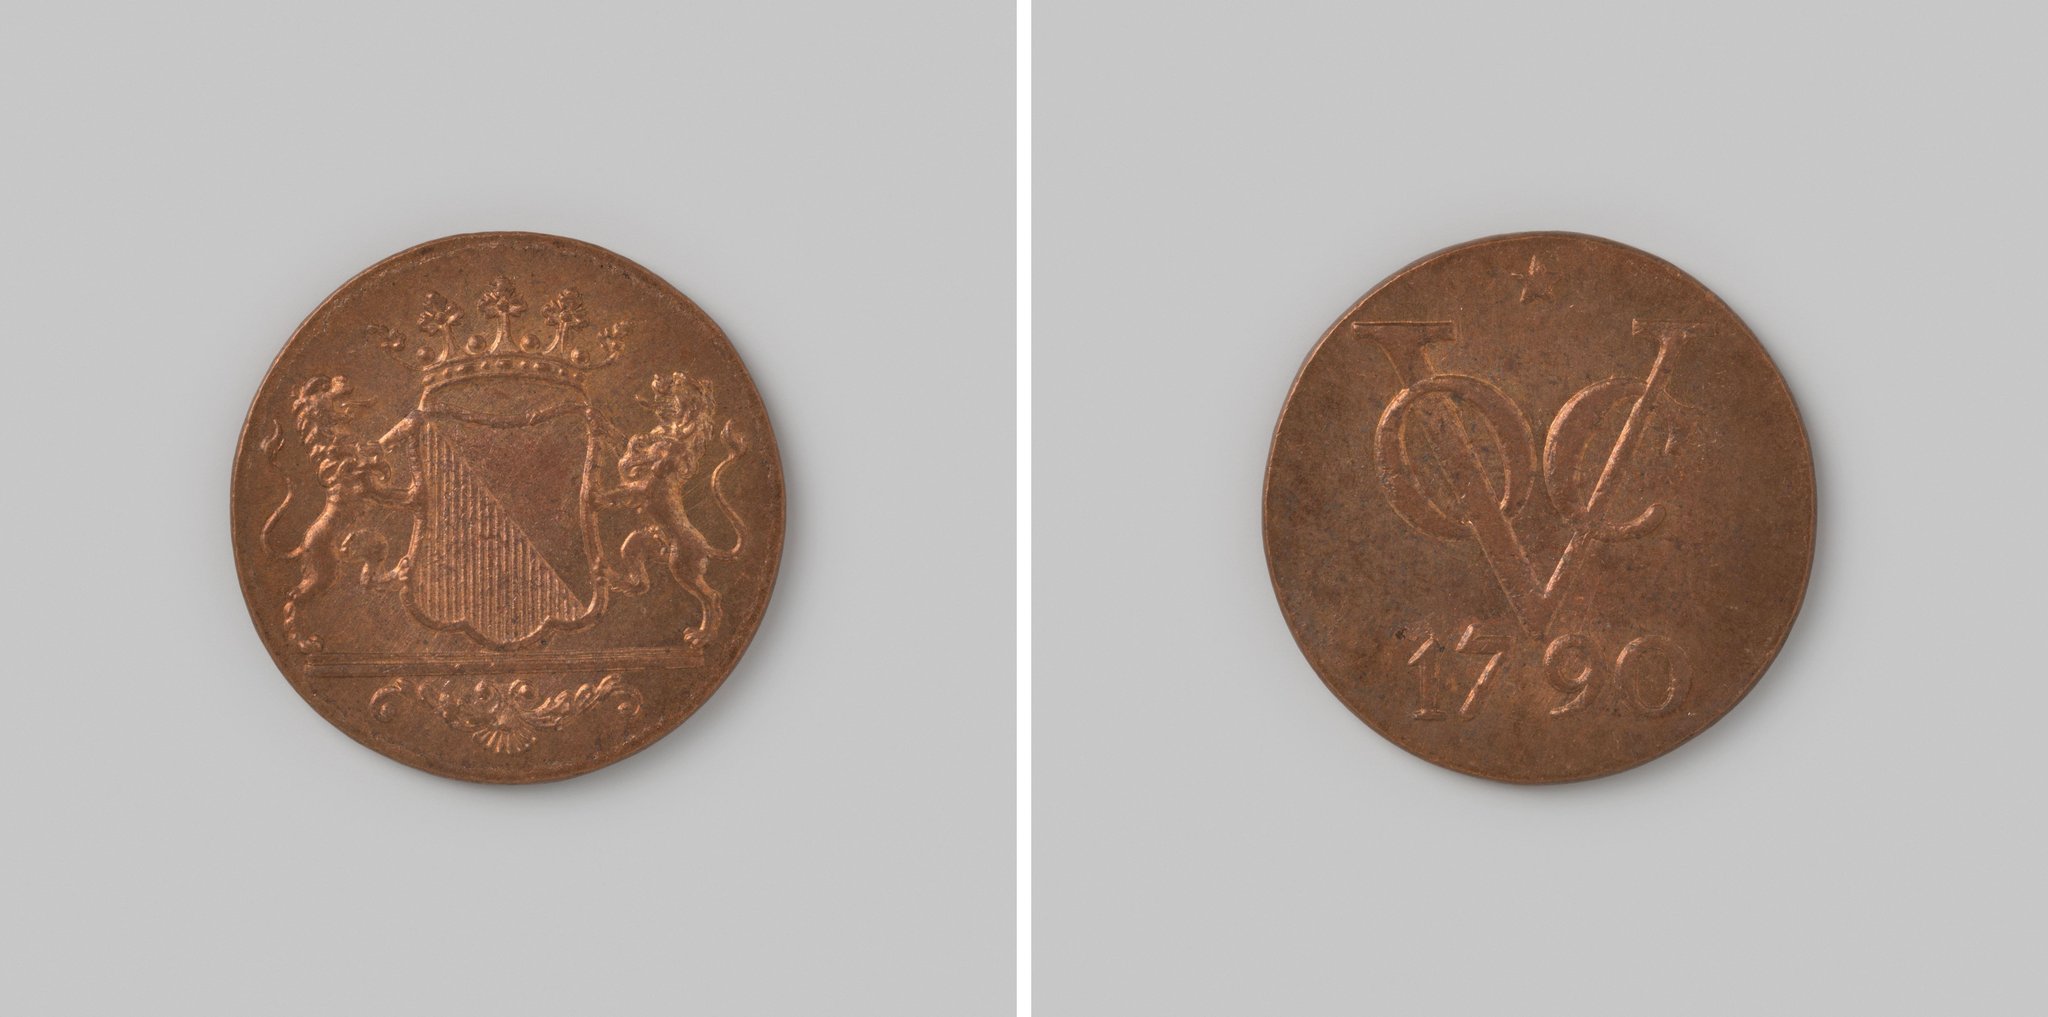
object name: coin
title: Dubbele duit op naam van de VOC en de stad Utrecht met jaartal1790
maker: william ii of the netherlands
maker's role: koning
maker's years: 1792-1849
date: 1840-1843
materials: copper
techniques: striking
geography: surabaya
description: Koperen munt. Voorzijde: op balk, waaronder guirlande, staand, door twee leeuwen gehouden gekroond wapenschild van de stad Utrecht. Keerzijde: monogram van de VOC, waarboven muntteken ster en waaronder fictief jaartal 1790. Gladde rand.